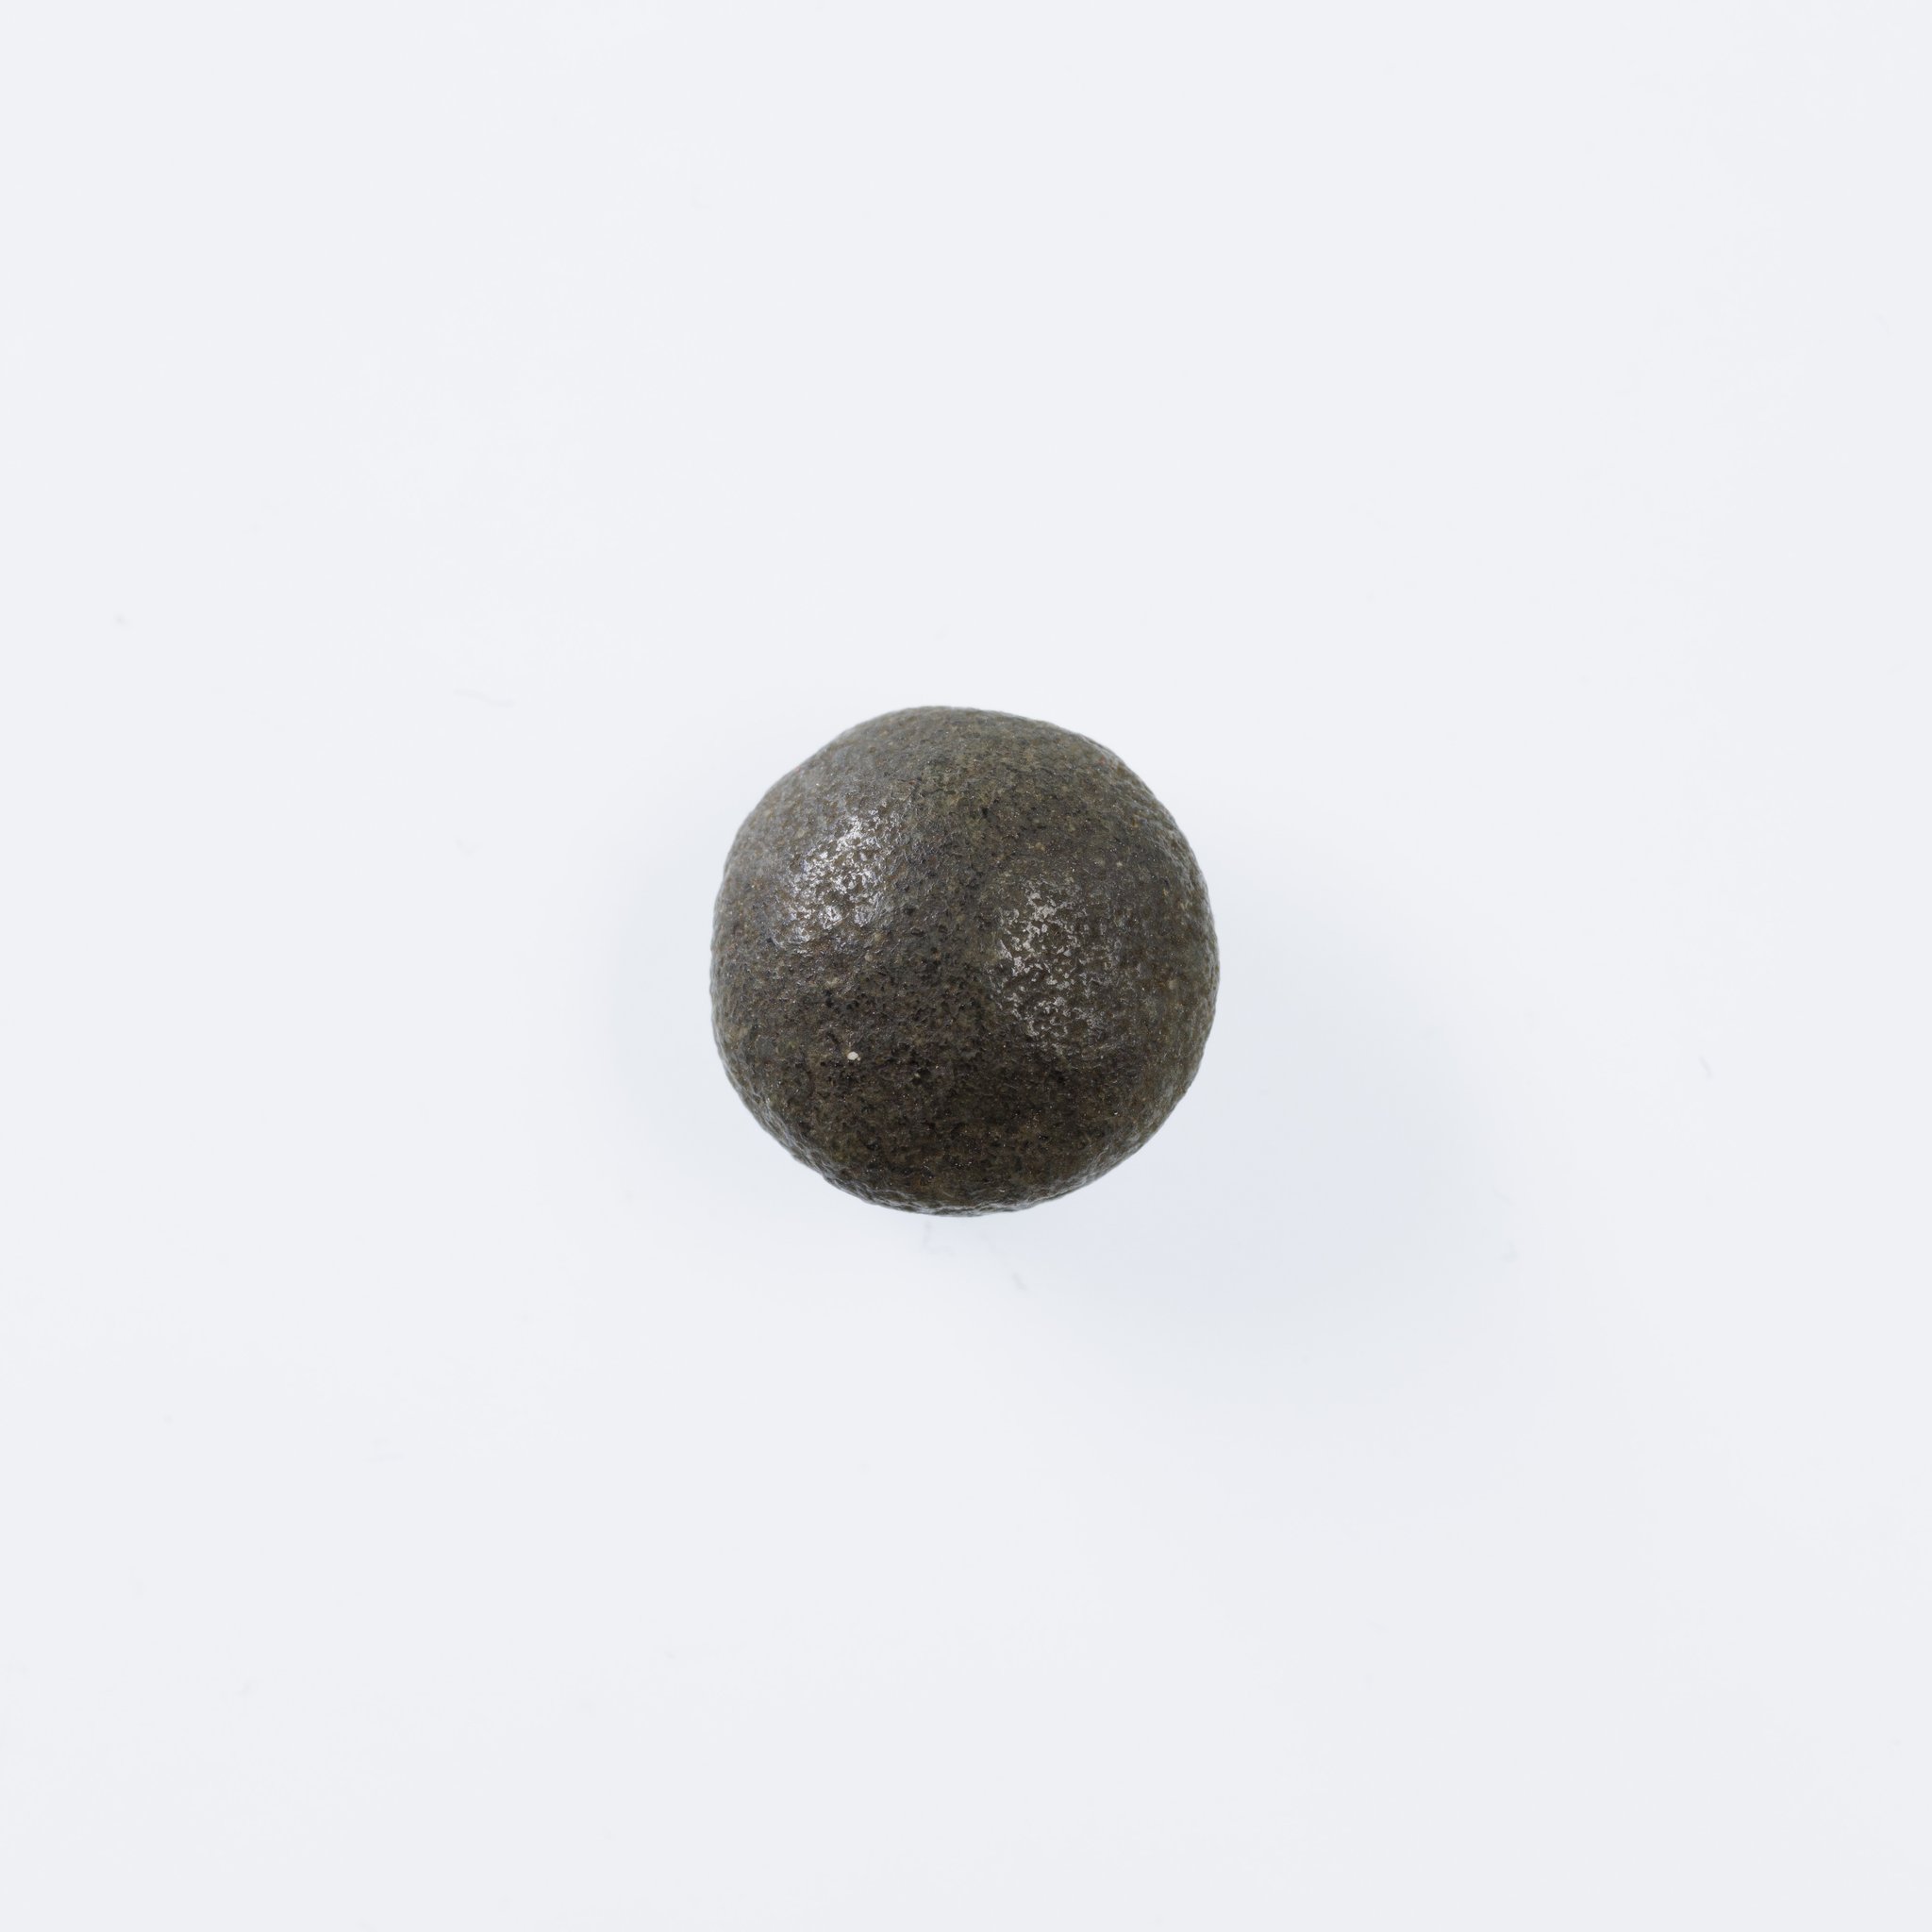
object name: weight, 1 4 kedet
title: Weight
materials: copper alloy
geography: egypt